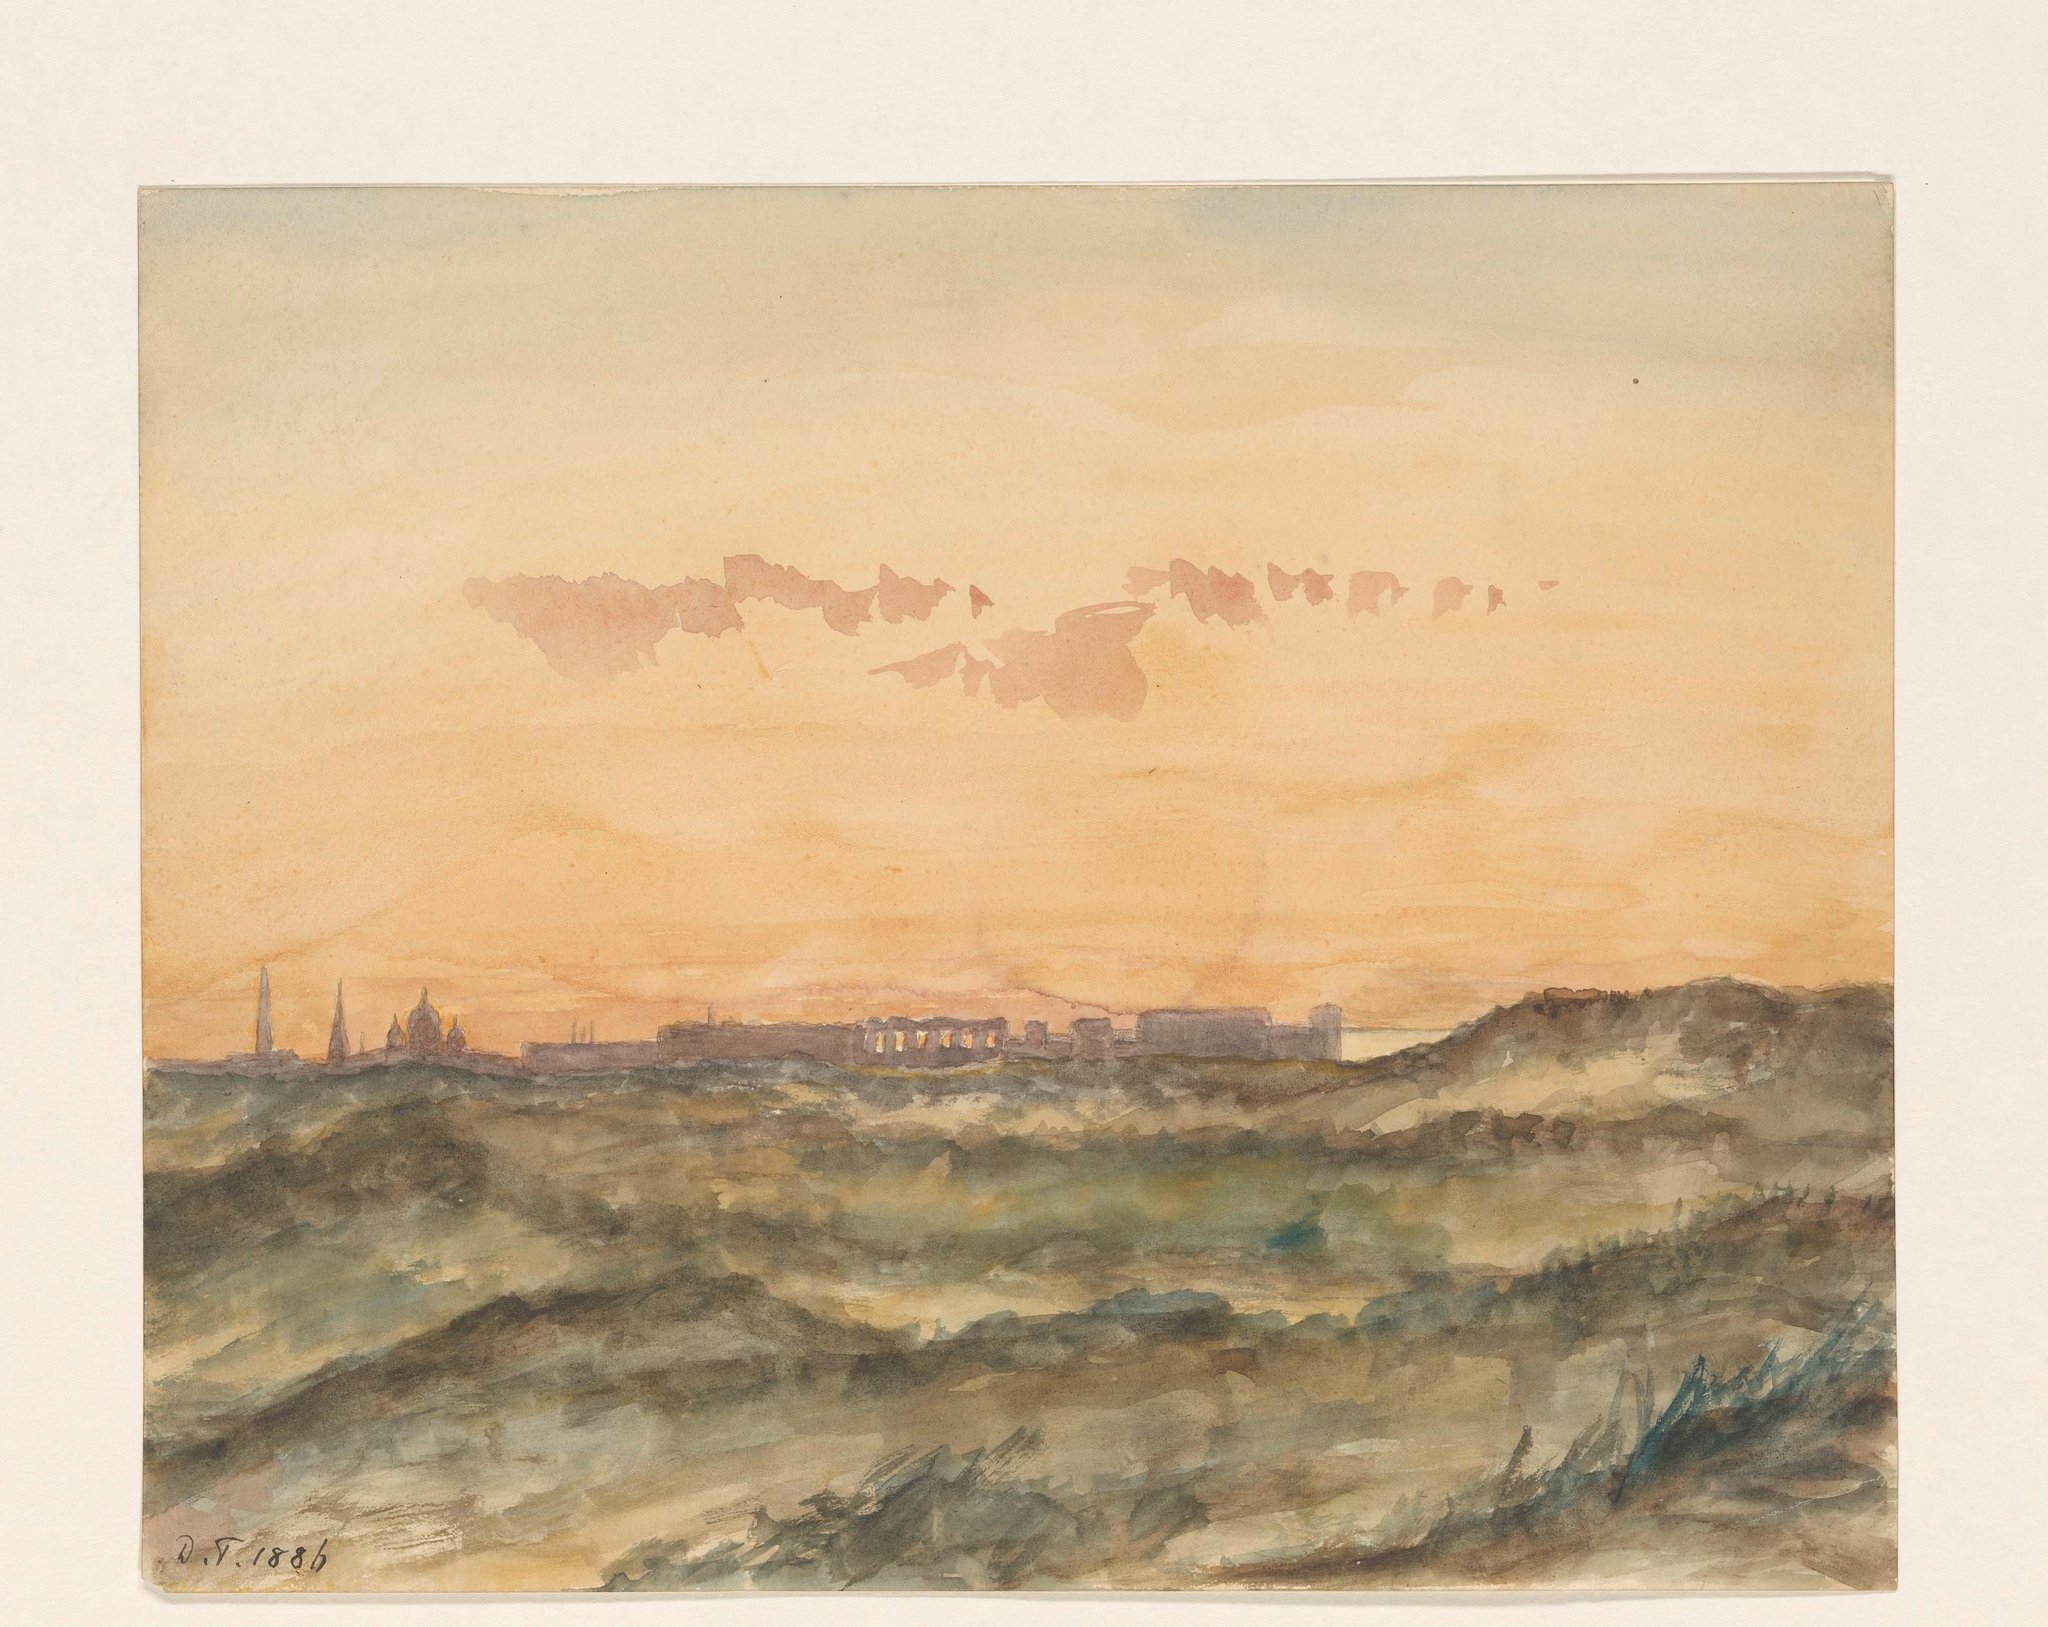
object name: watercolor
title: Landschap met in de verte het silhouet van een stad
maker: dirk arnoldus tavenraat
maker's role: draughtsman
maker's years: 1845-1930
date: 1886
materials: paper, pencil, watercolor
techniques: brush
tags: prospect of city, town panorama, silhouette of city